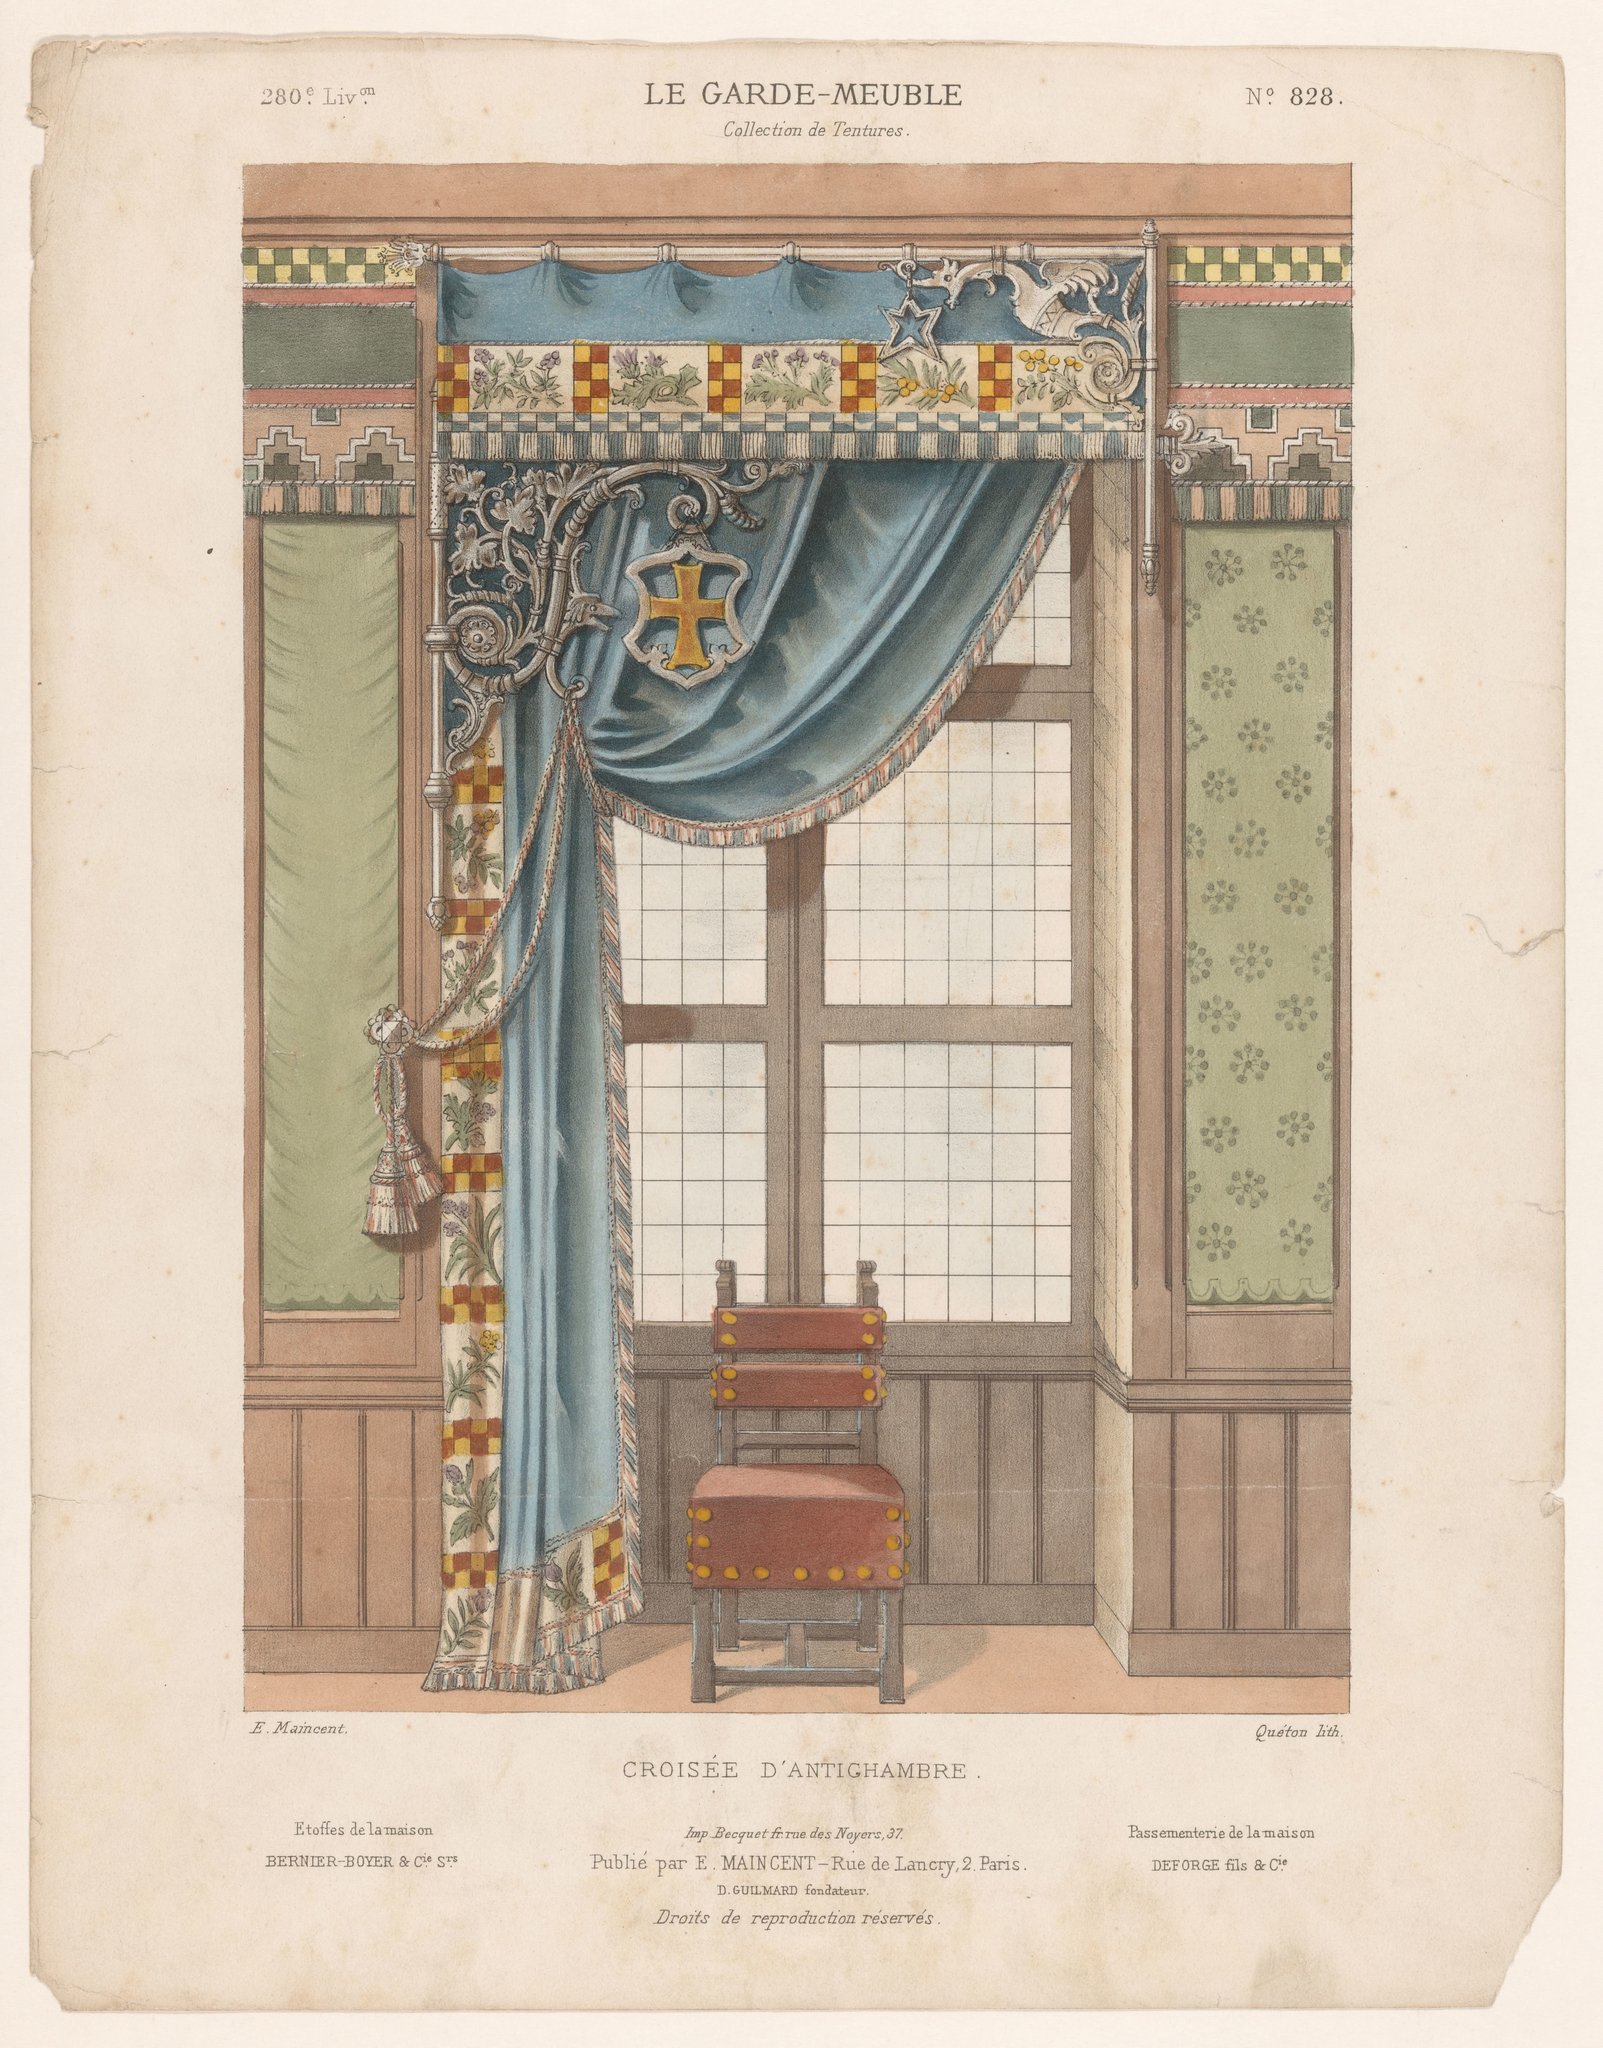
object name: print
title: Le Garde-Meuble / Collection de Tentures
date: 1885-1895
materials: paper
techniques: hand coloring, lithograph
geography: paris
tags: window, hangings and drapery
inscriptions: : ‘Droits de reproduction réservés.’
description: Kruisvenster van een voorvertrek met gedrapeerd gordijn. Prent uit 280e Livraison.